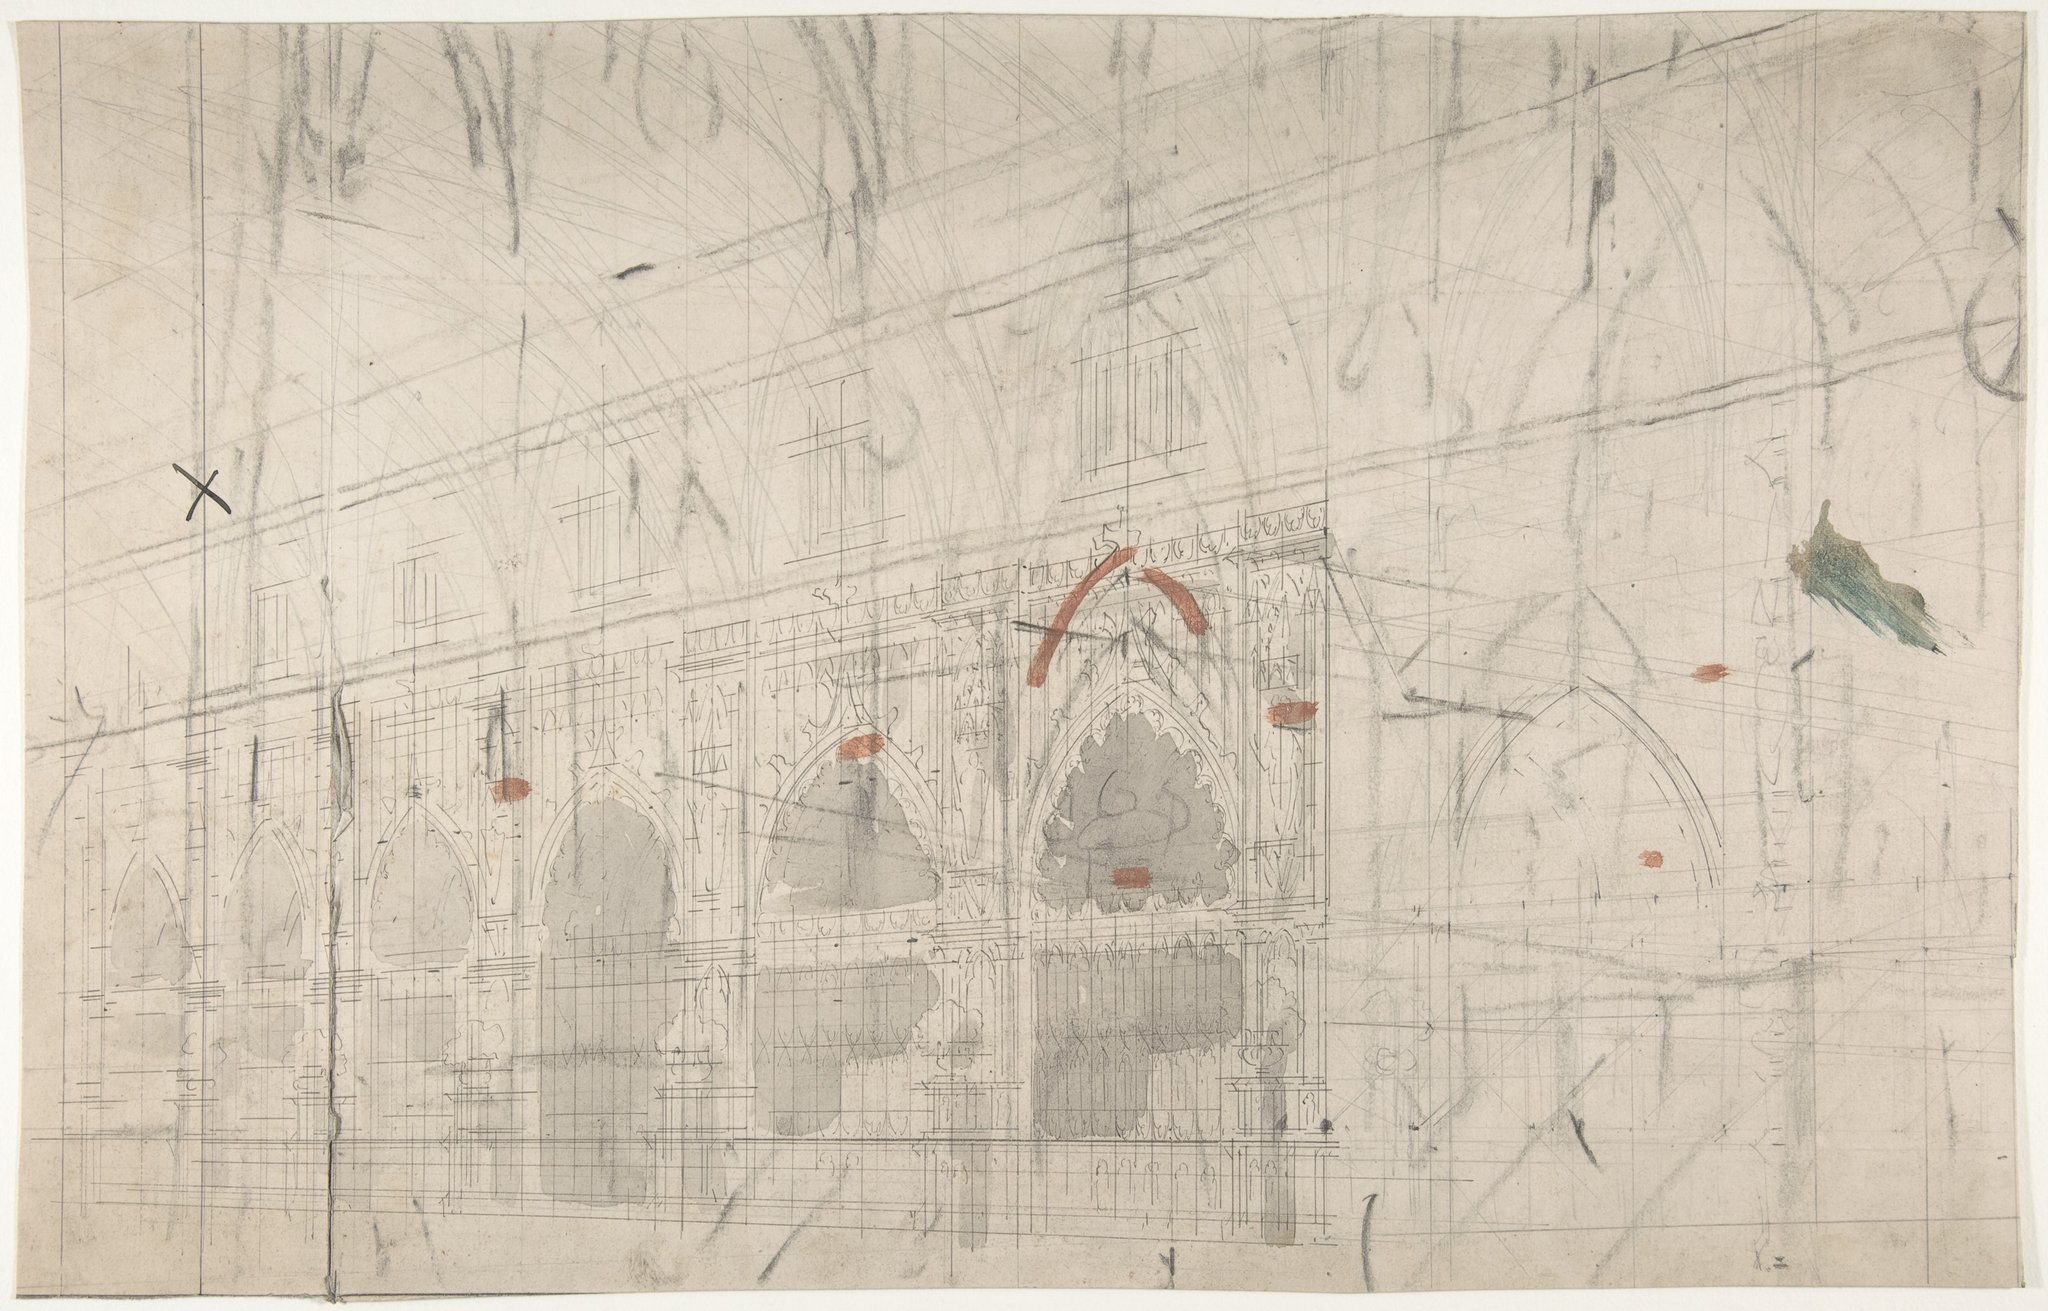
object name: drawing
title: Design for a Stage Set at the Opéra, Paris: Church Interior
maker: eugène cicéri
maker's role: artist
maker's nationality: french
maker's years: 1813-1890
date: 1830-1890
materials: gouache, graphite, ink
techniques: brush, pen, wash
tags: interiors,churches,stage design